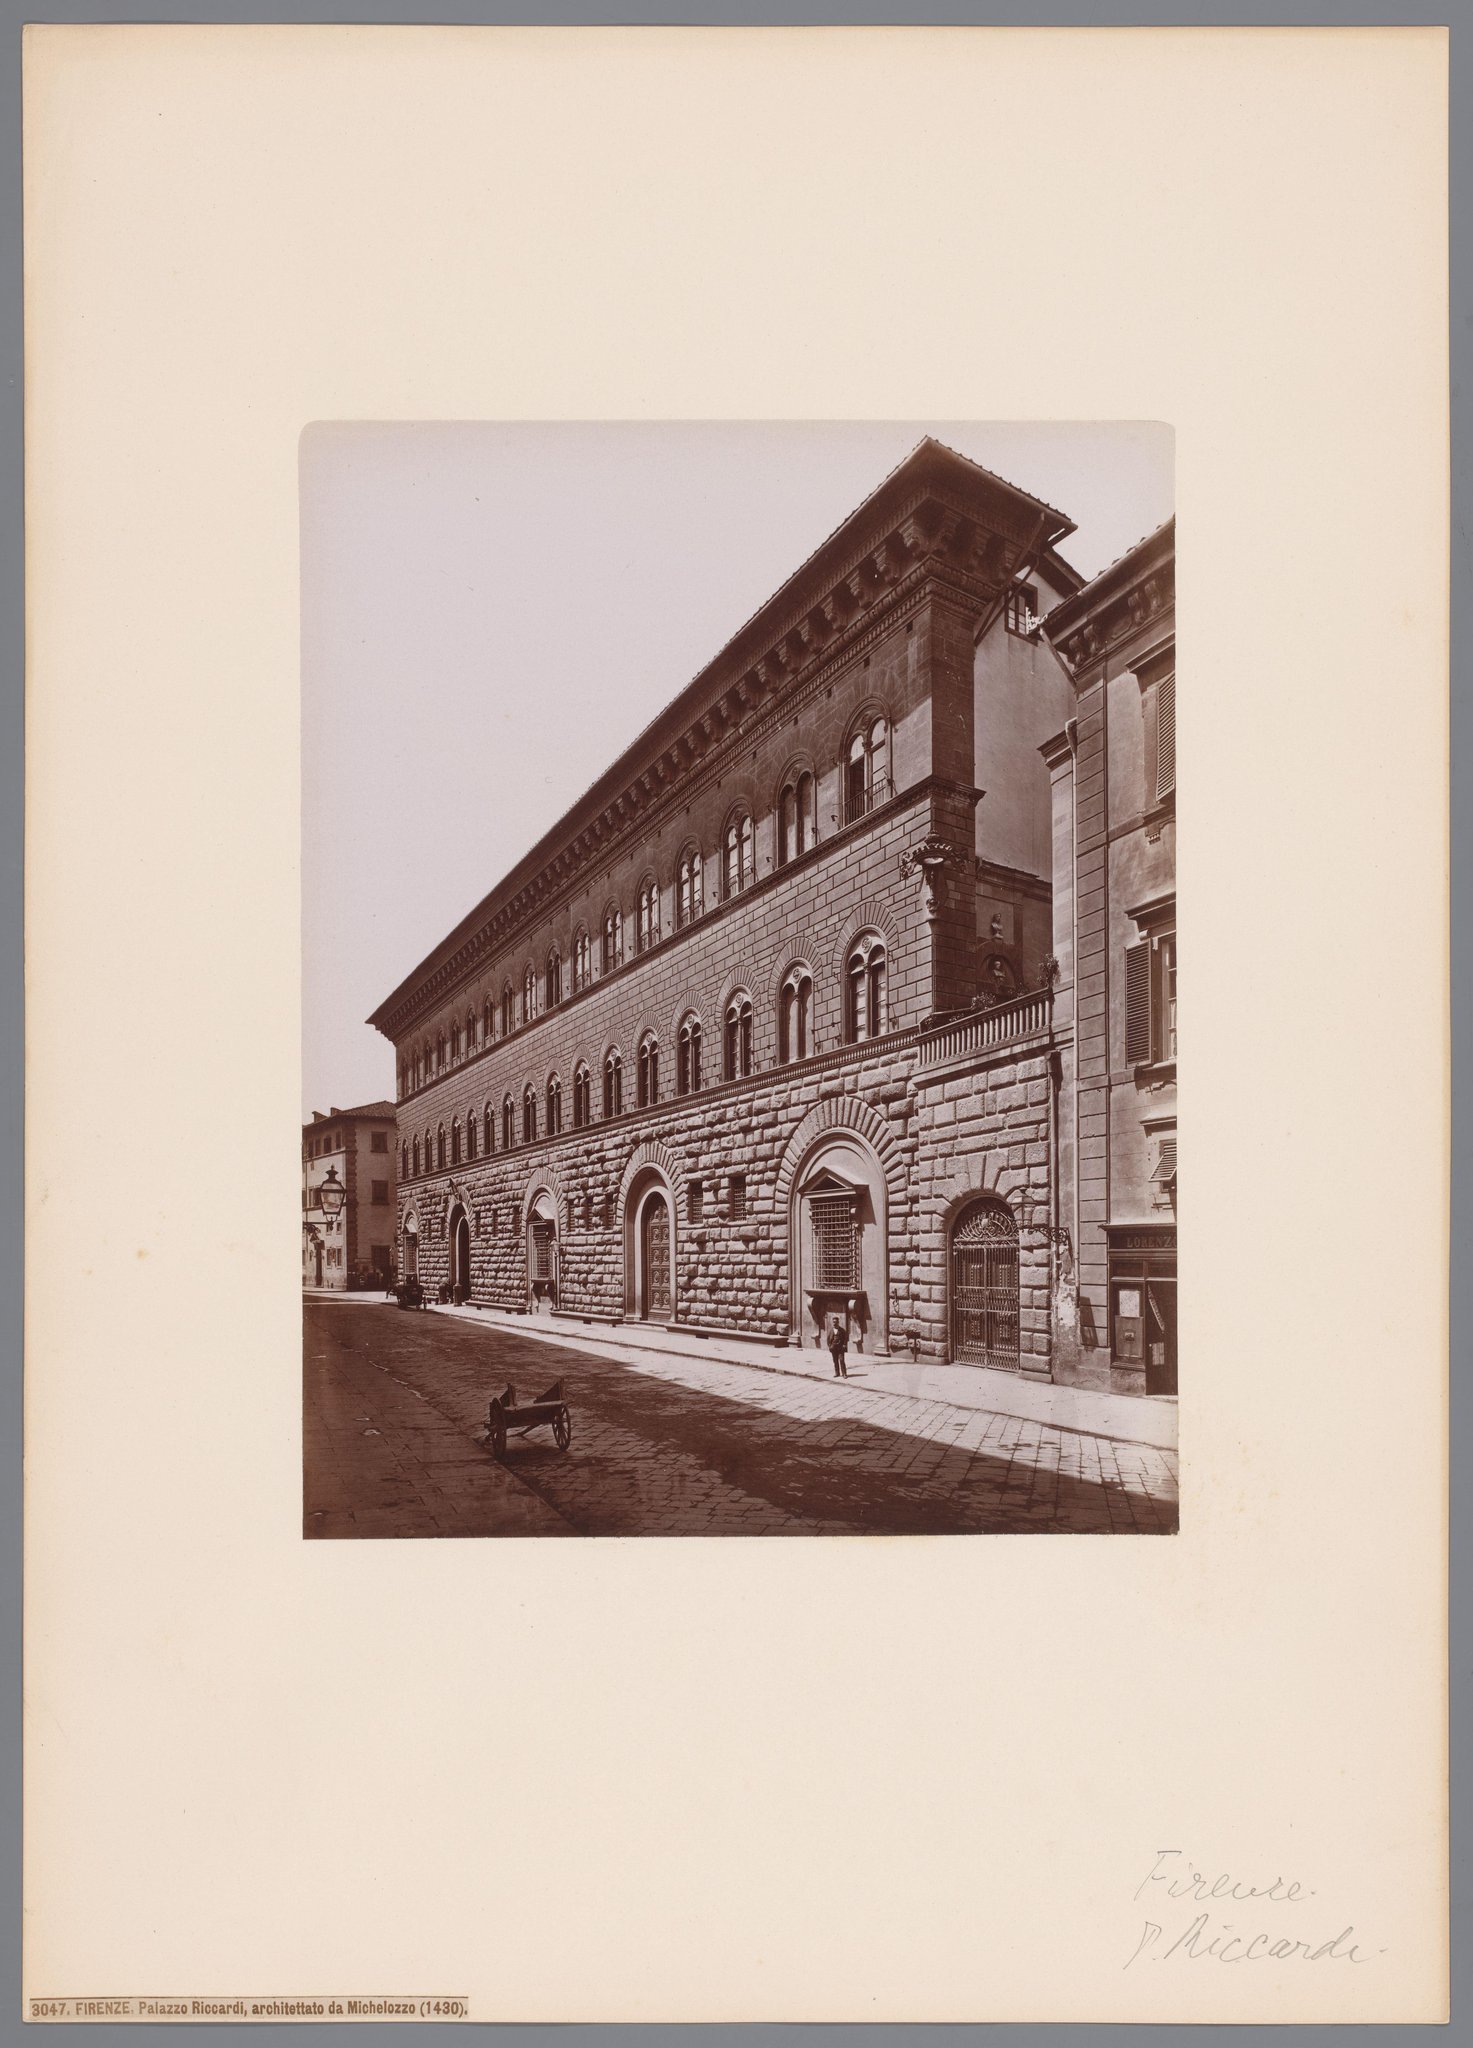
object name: photograph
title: Palazzo Riccardi, architettato da Michelozzo (1430)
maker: giacomo brogi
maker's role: fotograaf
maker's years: 1822-1881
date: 1864-1881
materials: cardboard, paper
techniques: albumen print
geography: florence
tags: palace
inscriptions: inscription: ‘Firenze/ Riccardi’, number: ‘3047.’, number: ‘37’